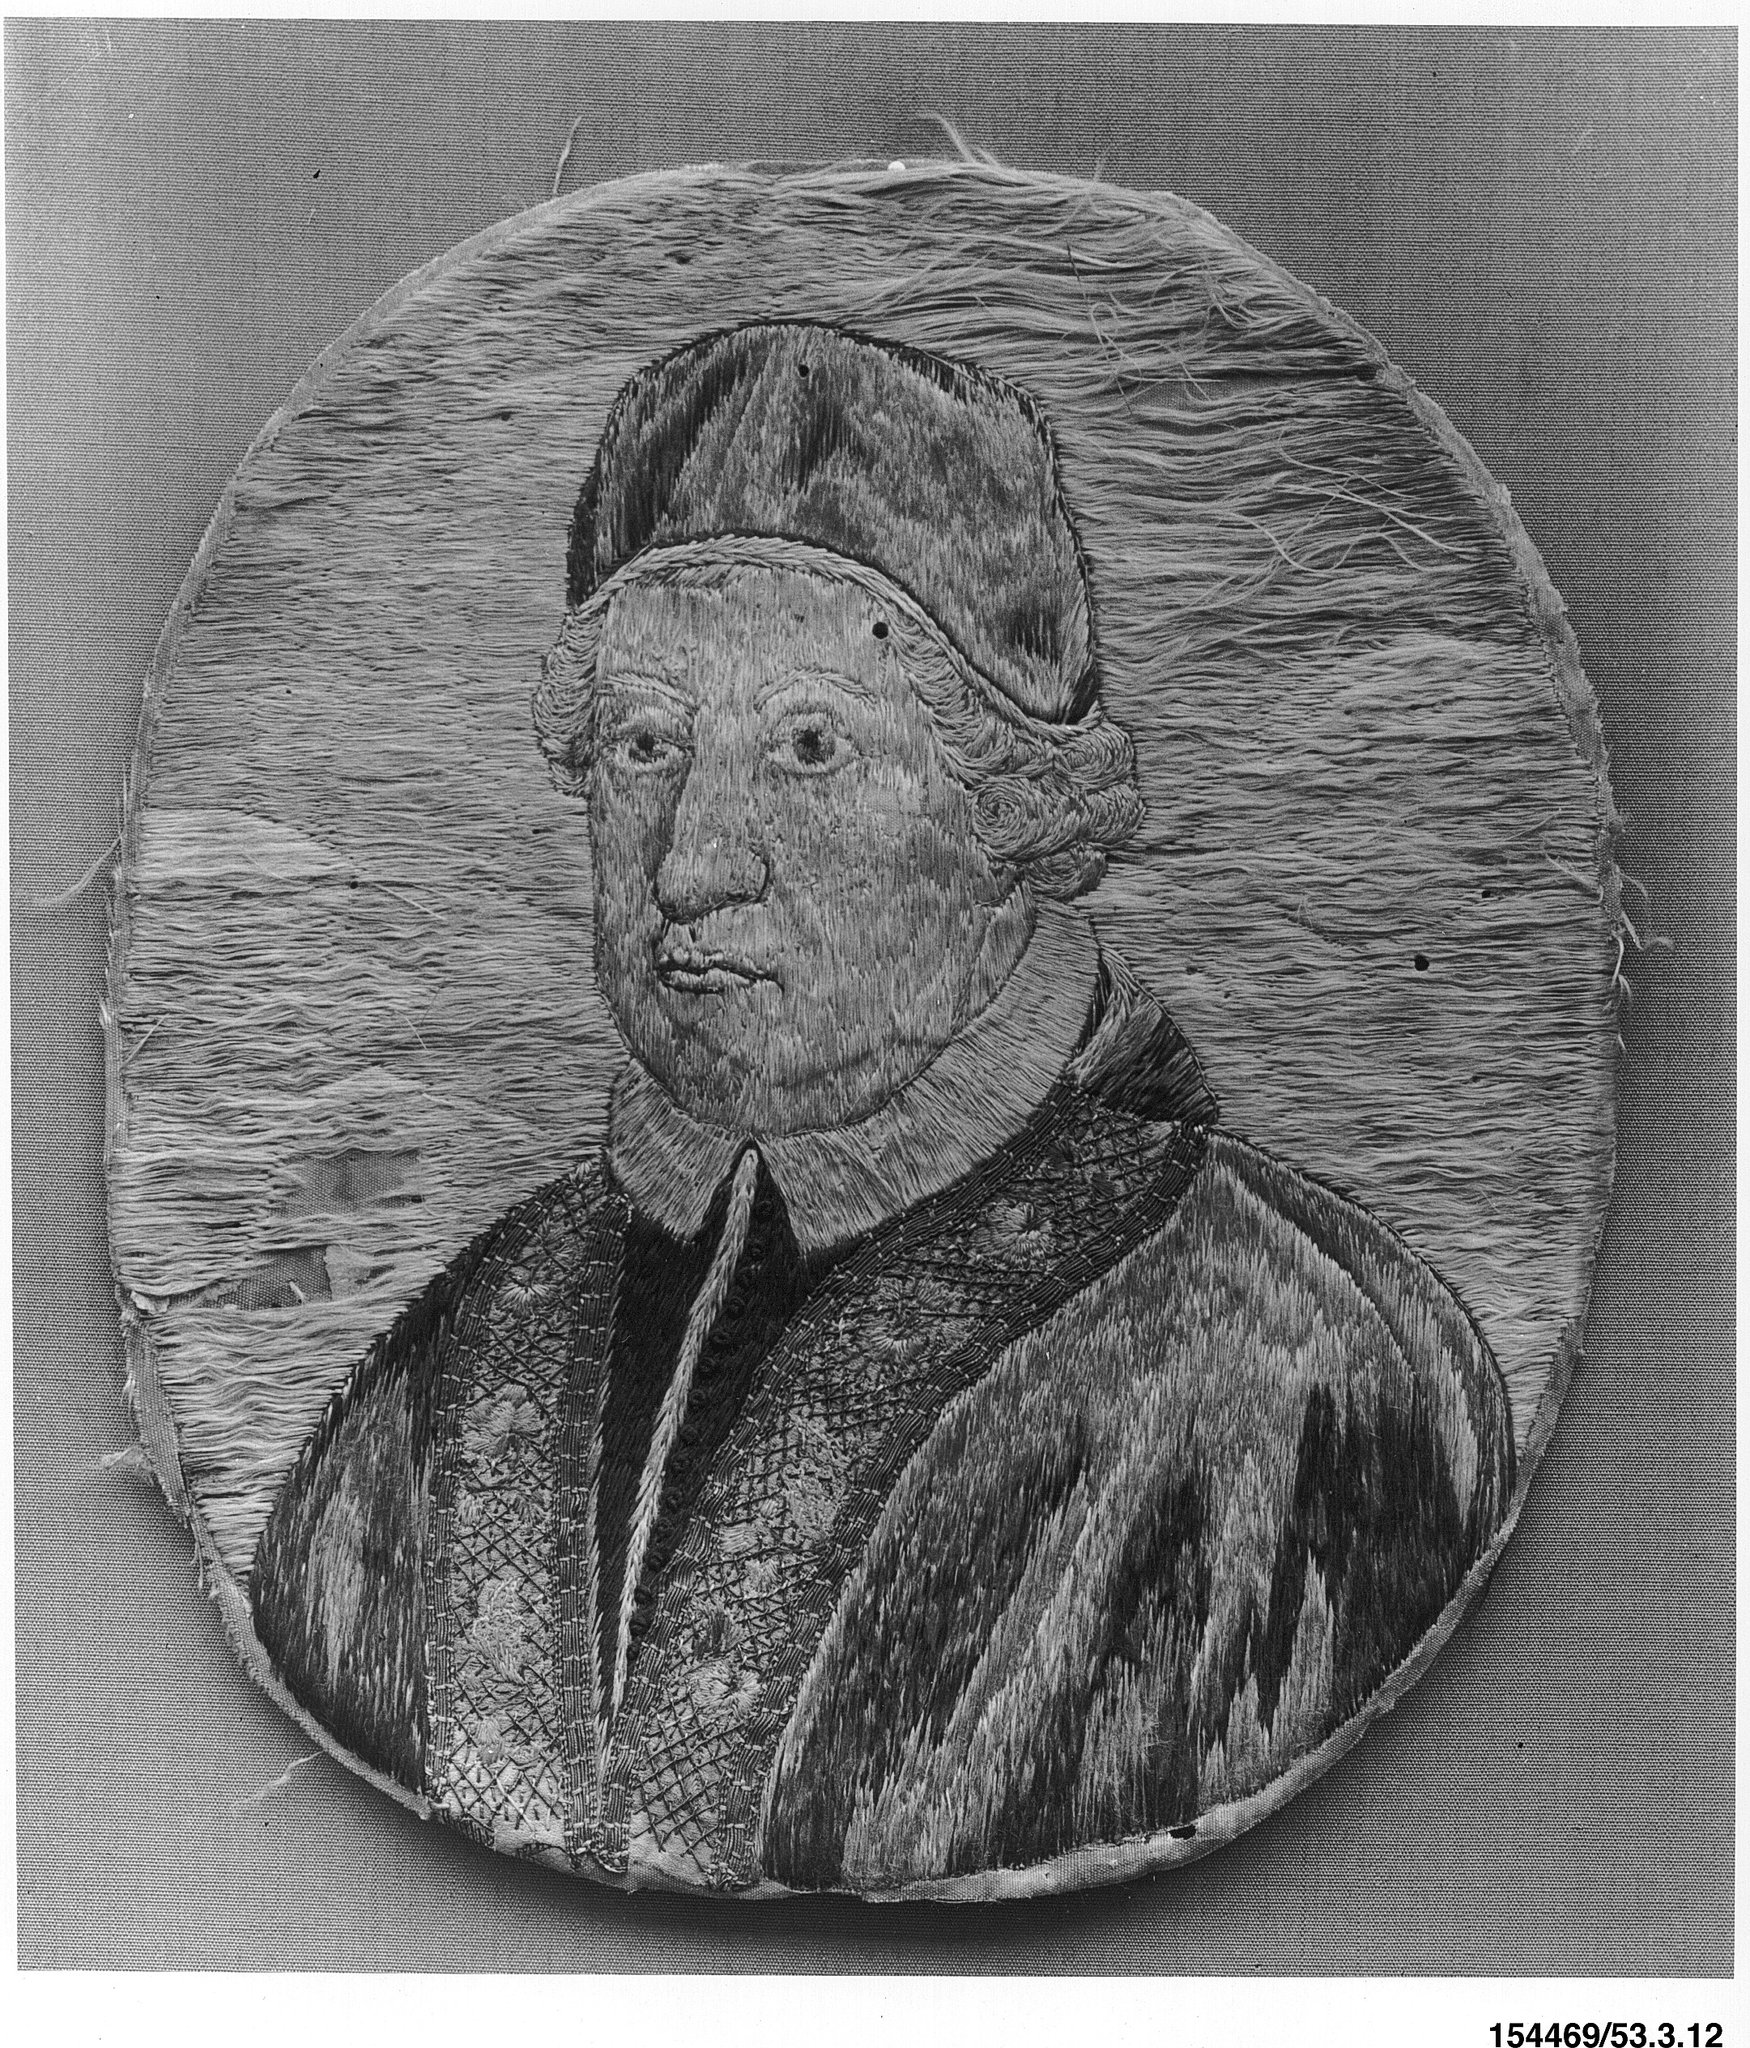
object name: medallion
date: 1701-1733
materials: linen, metal thread, silk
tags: men,portraits